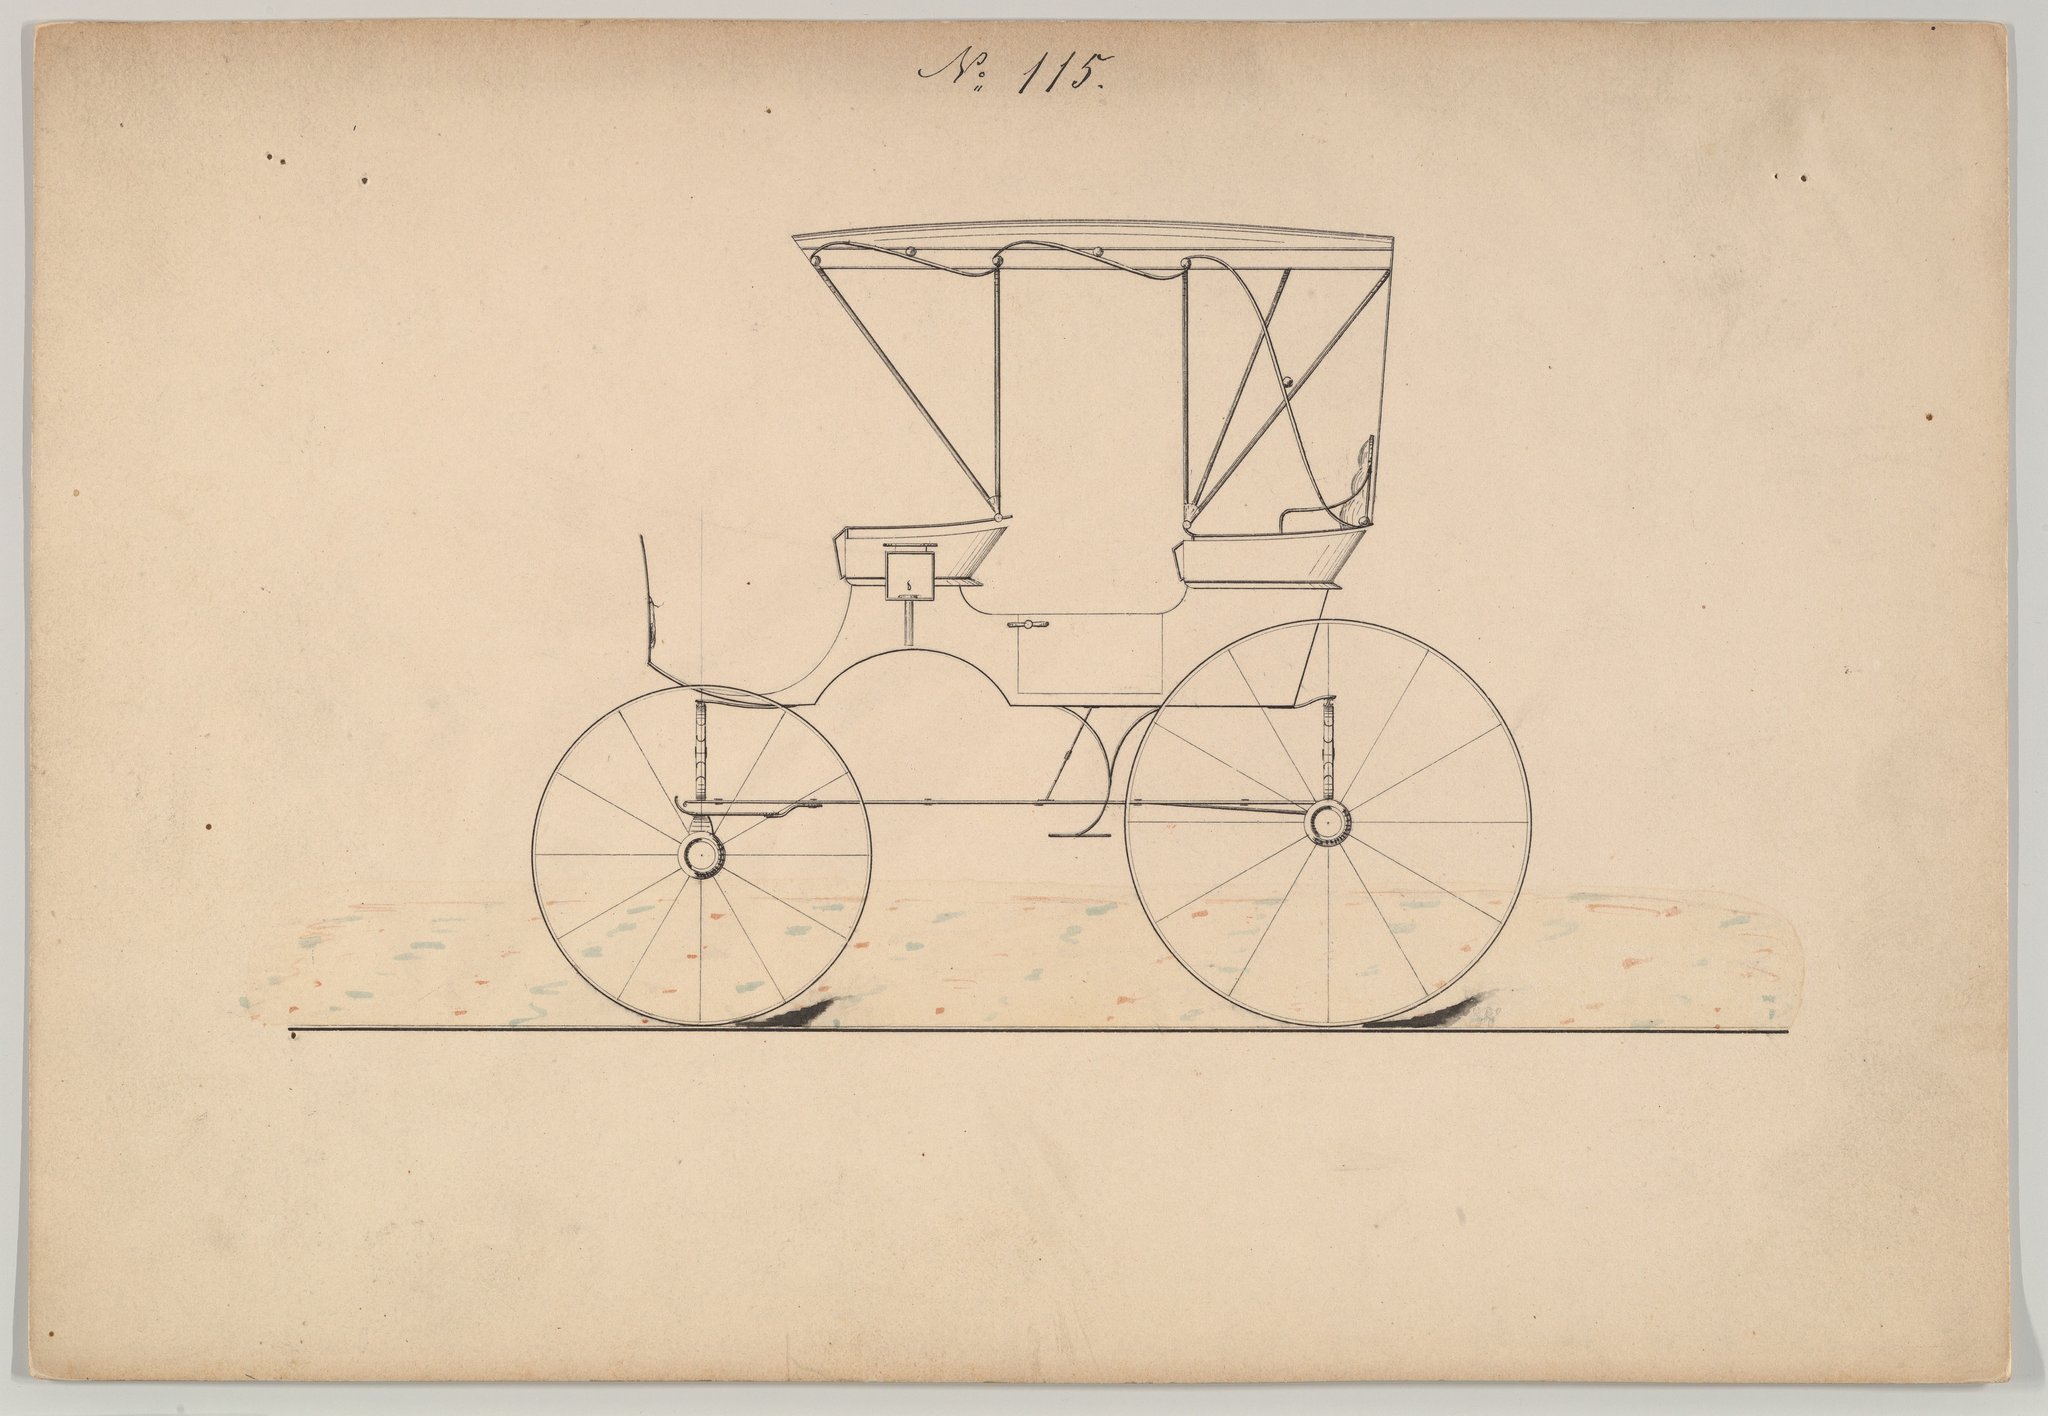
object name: drawing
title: Extension Top Phaeton #115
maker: brewster & co.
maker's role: manufacturer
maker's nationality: american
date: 1865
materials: ink, watercolor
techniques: pen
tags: carriages